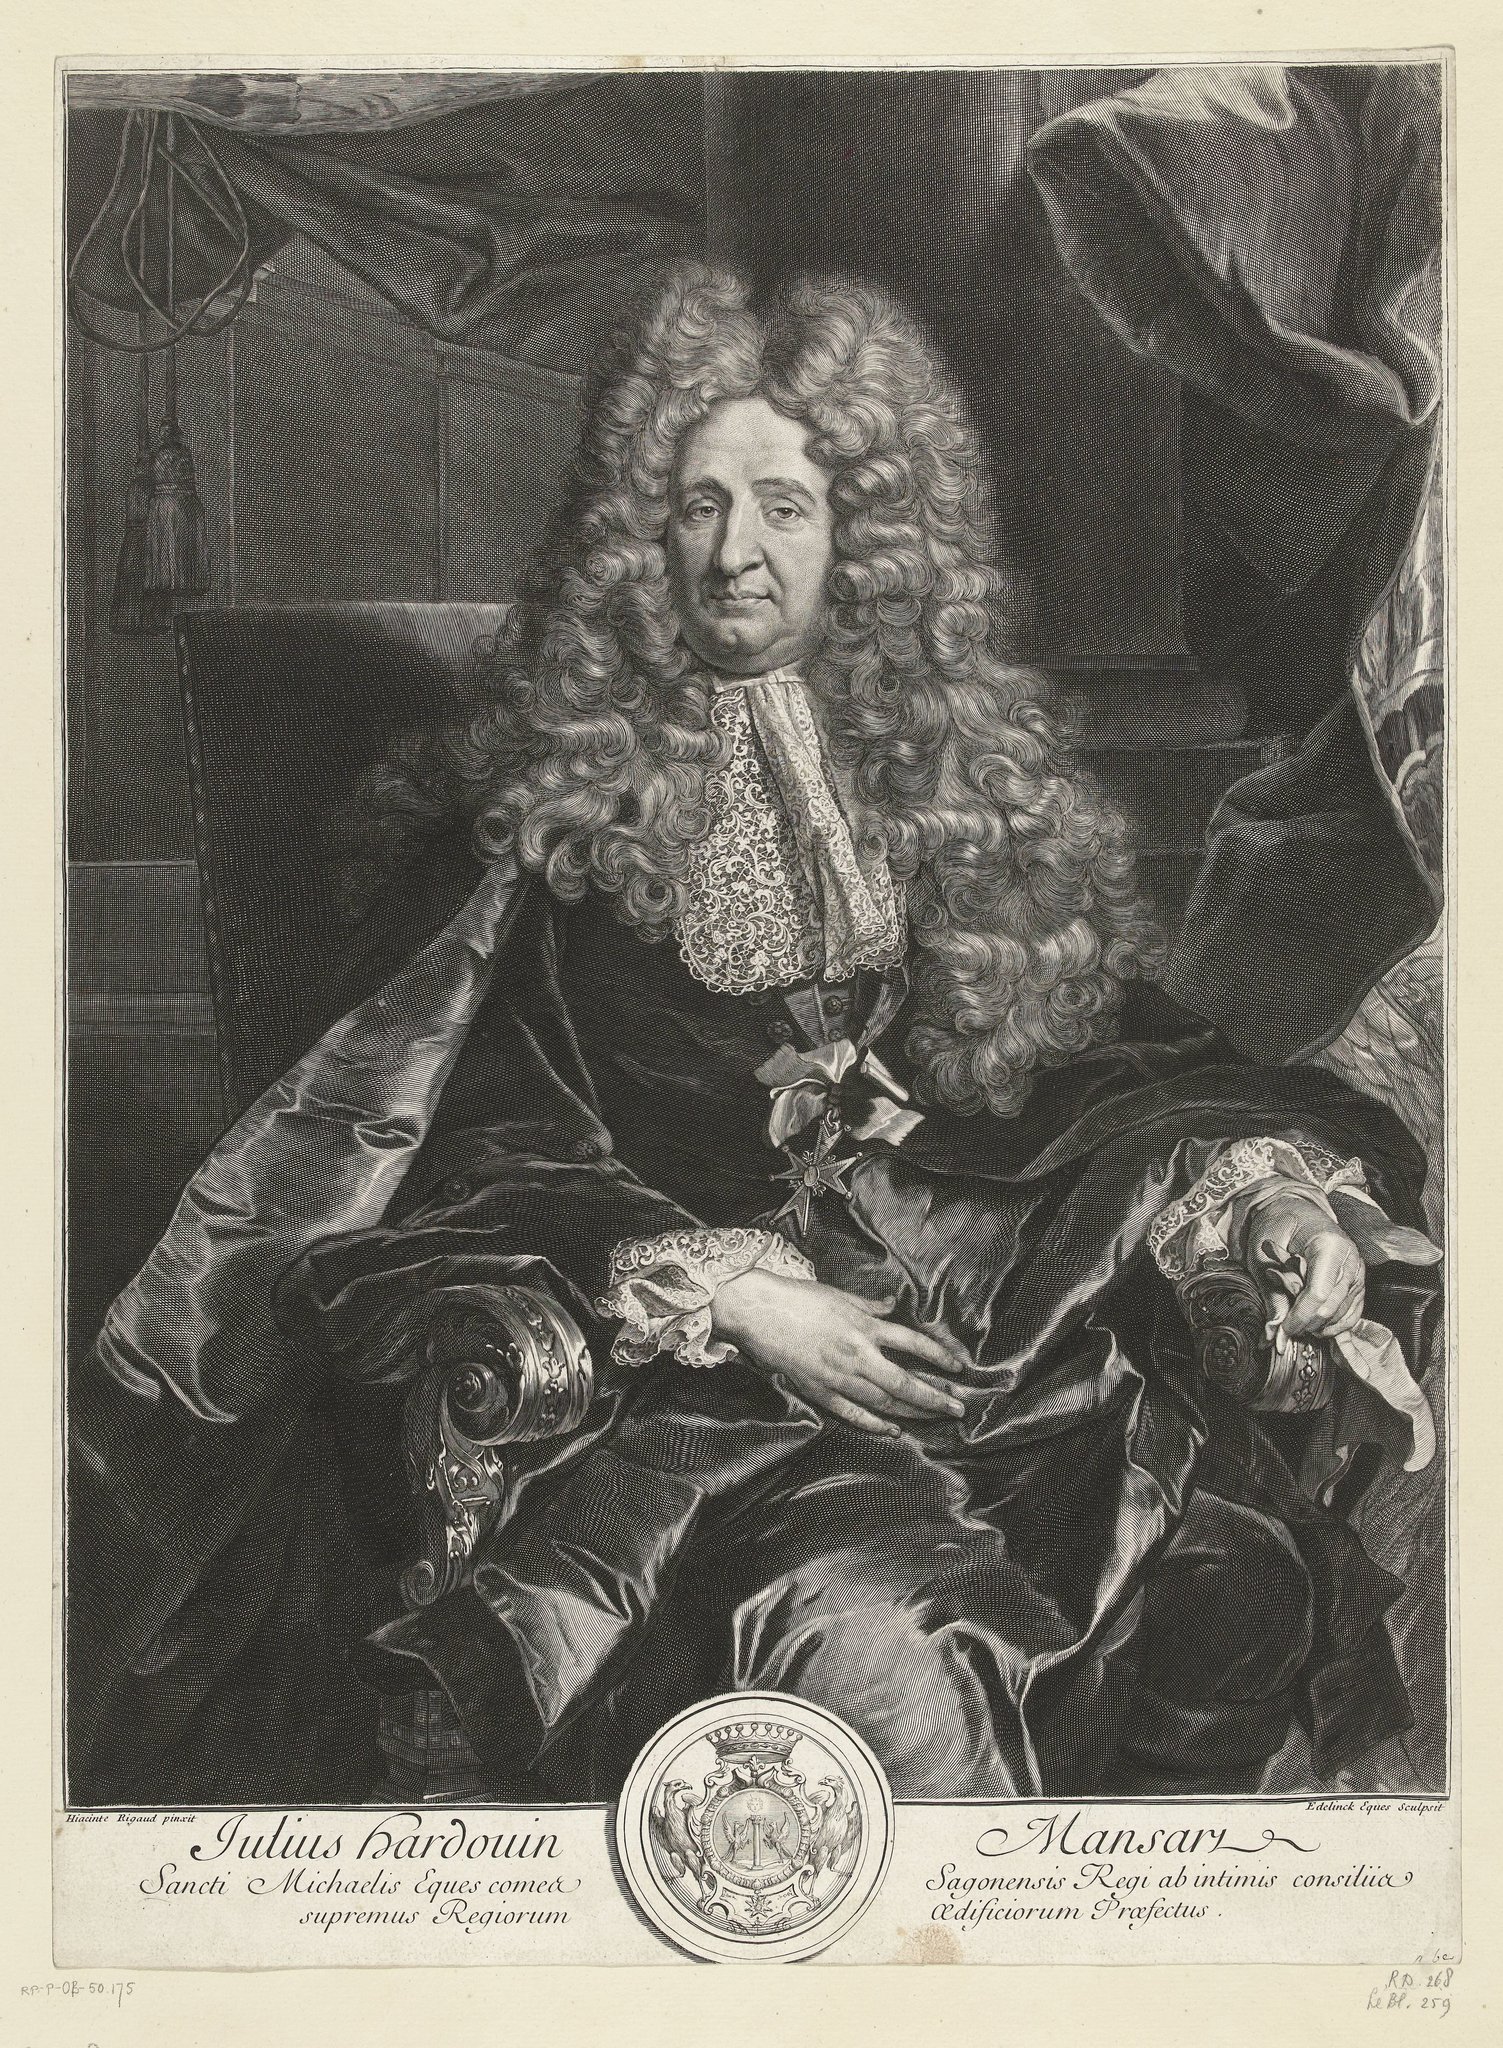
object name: print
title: Julius Hardouin Mansart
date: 1666-1707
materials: paper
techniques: engraving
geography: france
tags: paris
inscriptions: collector's mark: Lugt 240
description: De Franse architect Jules Hardouin-Mansart (1646-1708), afgebeeld zittend in stoel, met op de achtergrond een draperie en een pilaar. Onderaan een wapen en drie regels tekst in Latijn.